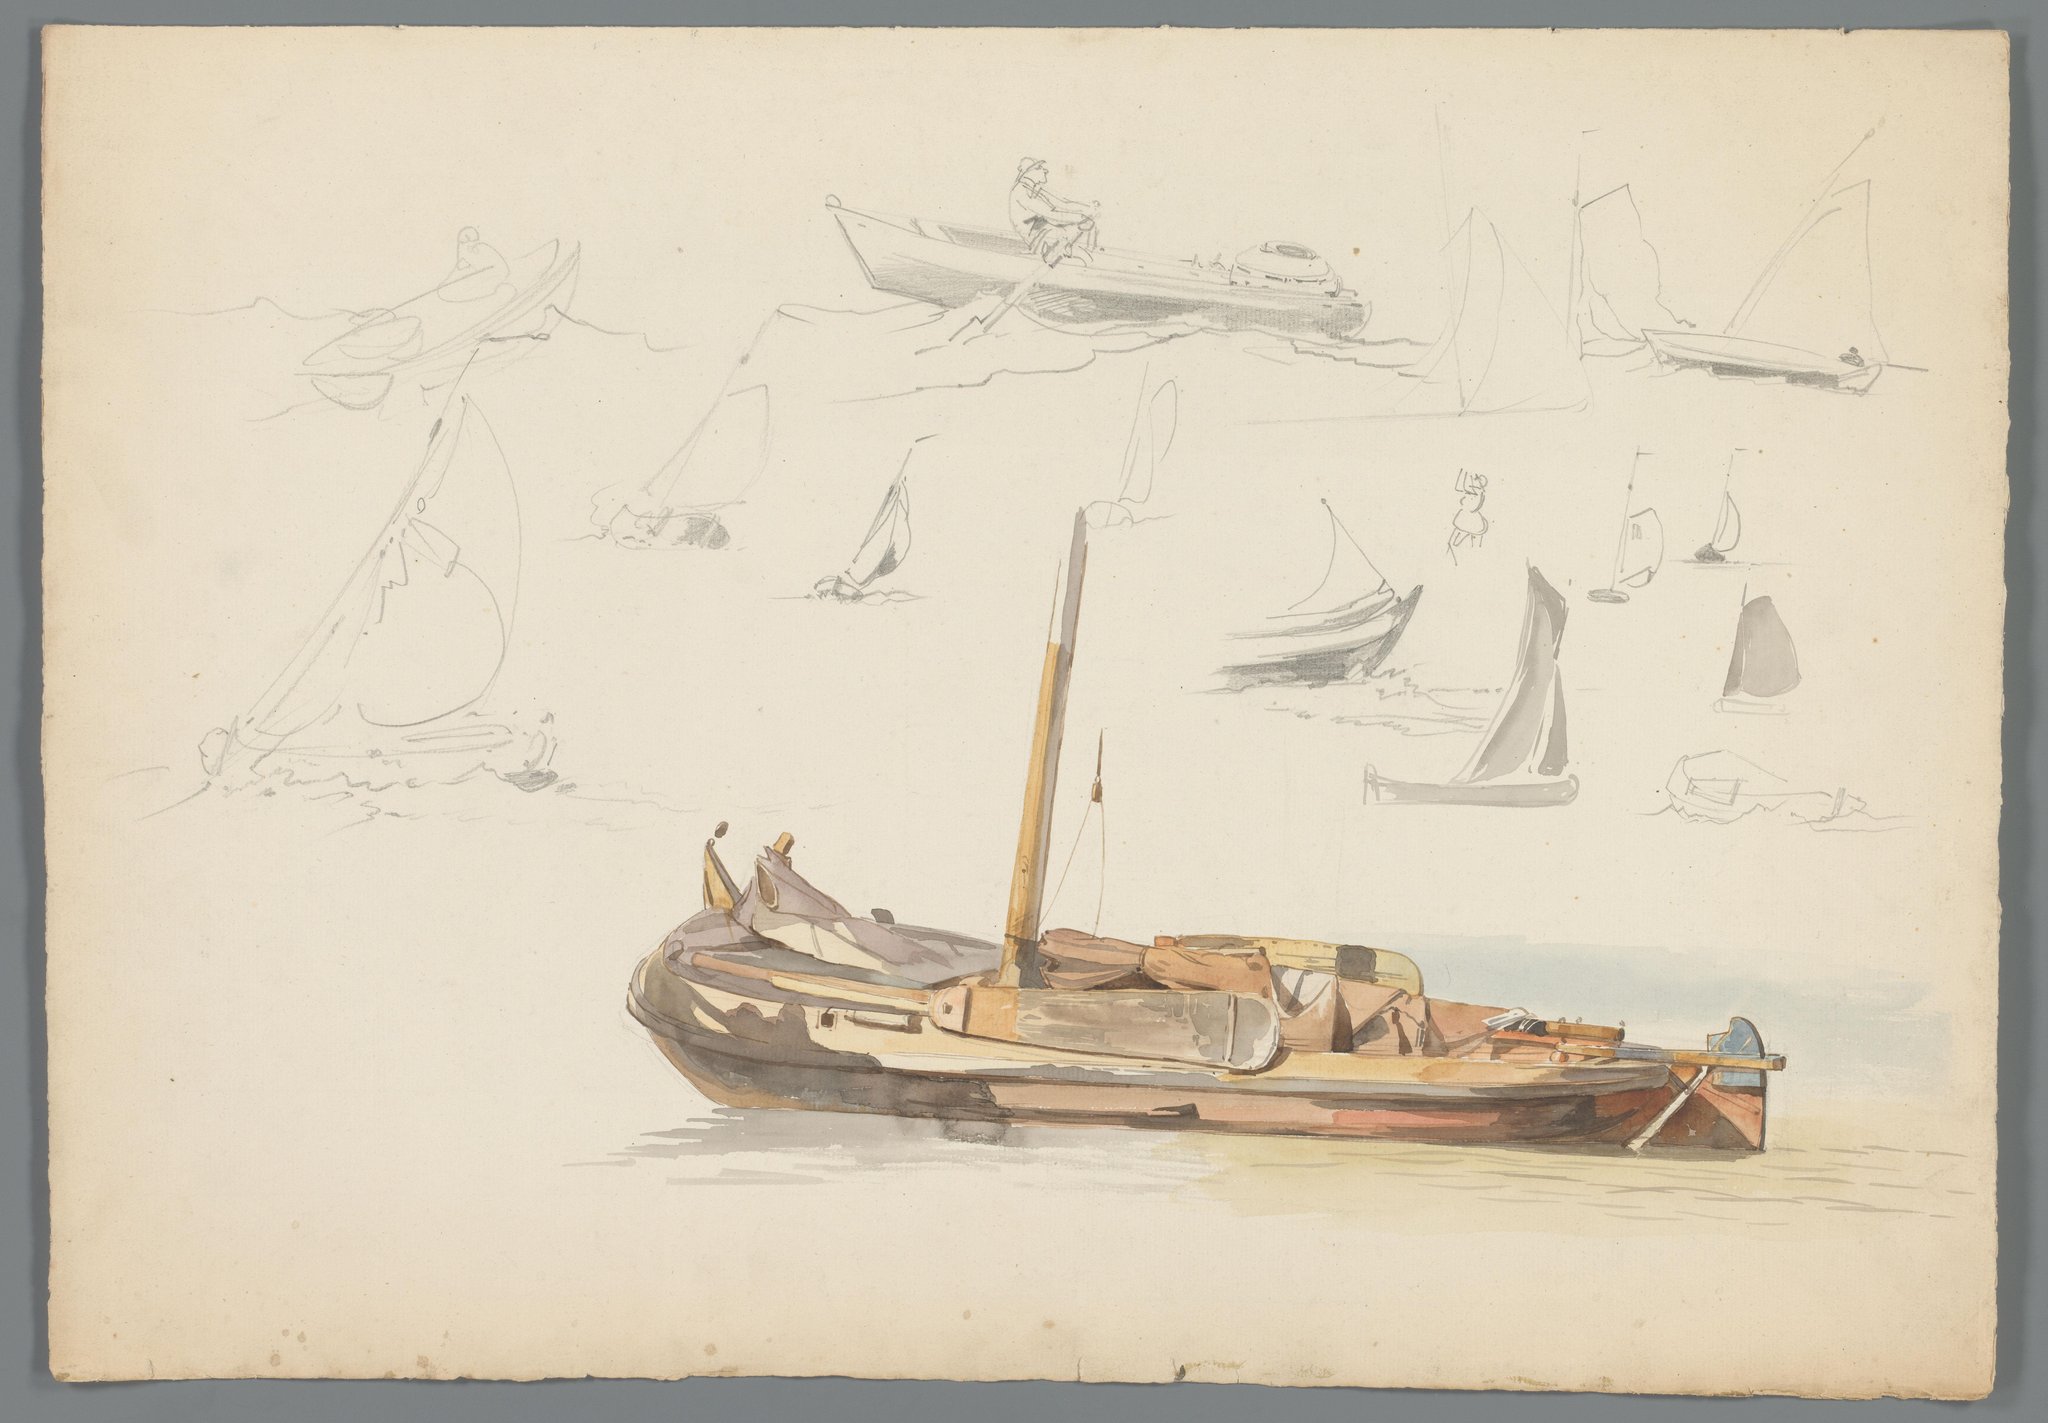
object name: drawing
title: Studieblad met verschillende soorten schepen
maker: willem anthonie van deventer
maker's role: draughtsman, painter, print maker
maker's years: 1824-1893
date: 1834-1893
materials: paper, pencil, watercolor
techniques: brush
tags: sailing-ship, sailing-boat, rowing-boat, canoe, etc.